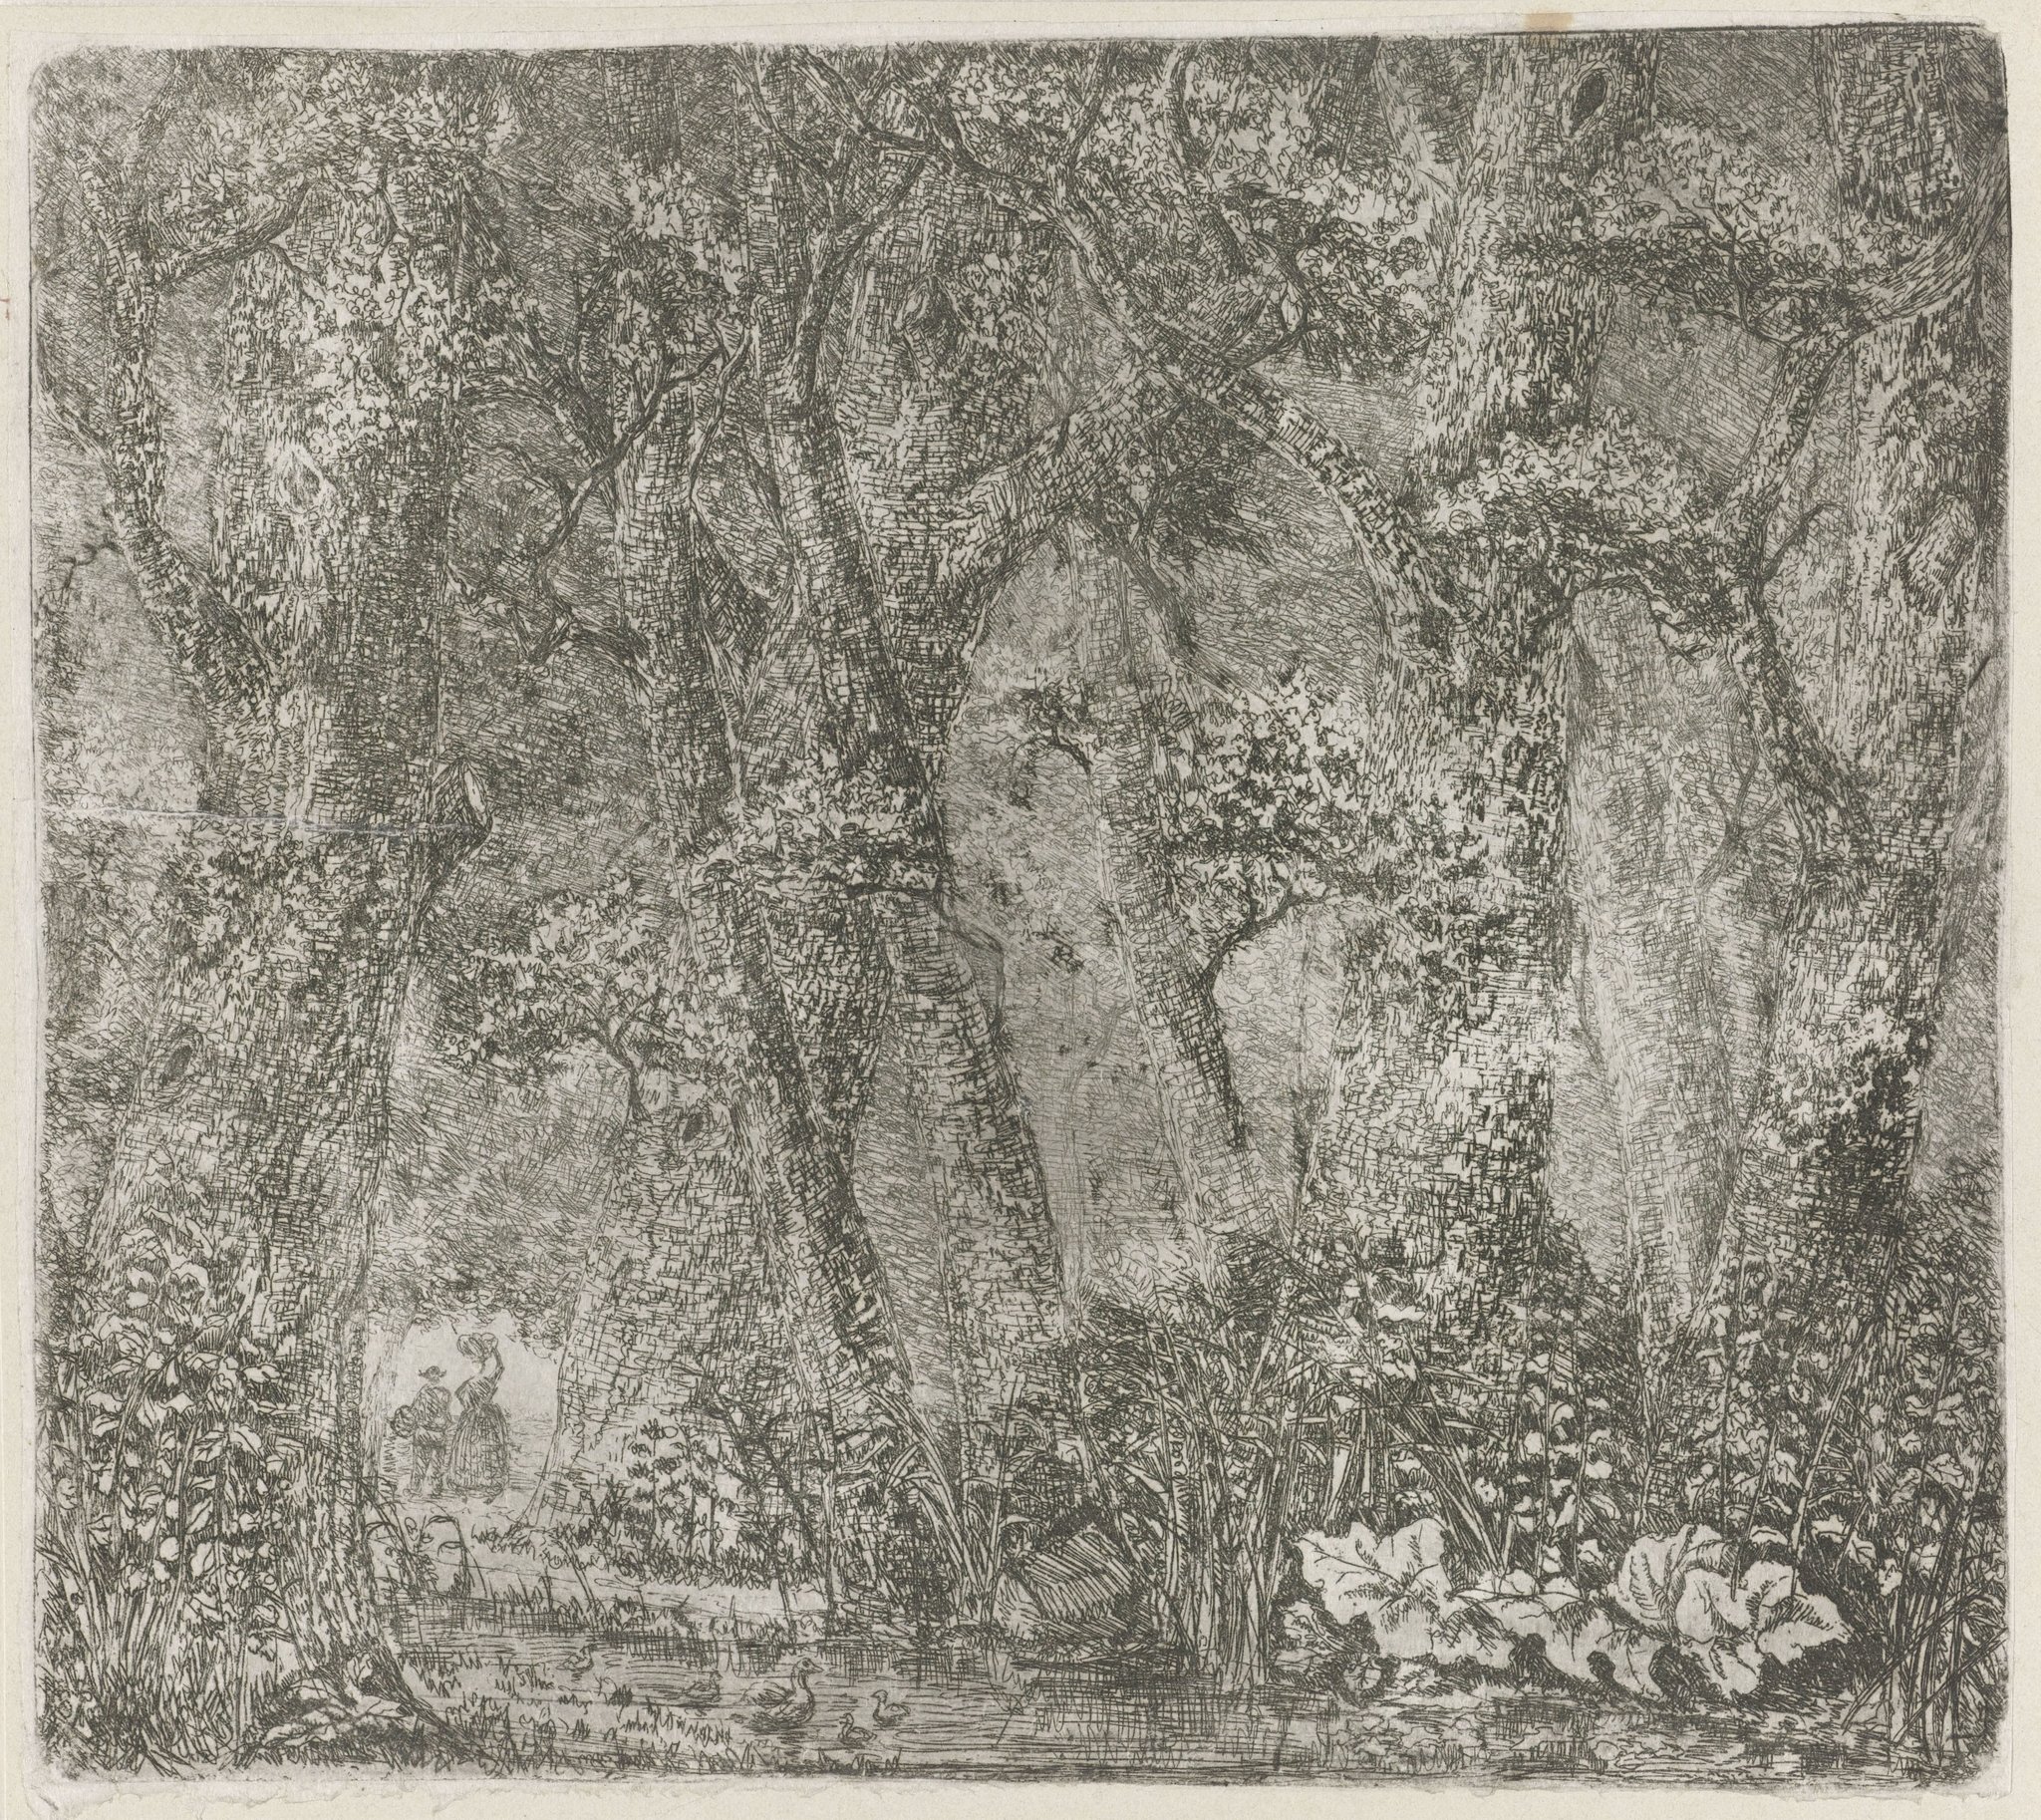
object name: print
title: Groep zwaar boomgewas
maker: eberhard cornelis rahms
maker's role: print maker, publisher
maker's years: 1823-1907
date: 1806-1860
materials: paper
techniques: etching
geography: oudewater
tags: forest, wood, water meadows, water-birds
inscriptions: inscription: ‘Koper - N 11 geetst Juny 1860 / Groep zwaar Boomgewas / ECR / Zelf Gedrukt Juny 1860’, collector's mark: Lugt 2228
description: Gezicht op een stuk bos met op de voorgrond een watertje met enkele watervogels. Links op de achtergrond twee figuren.